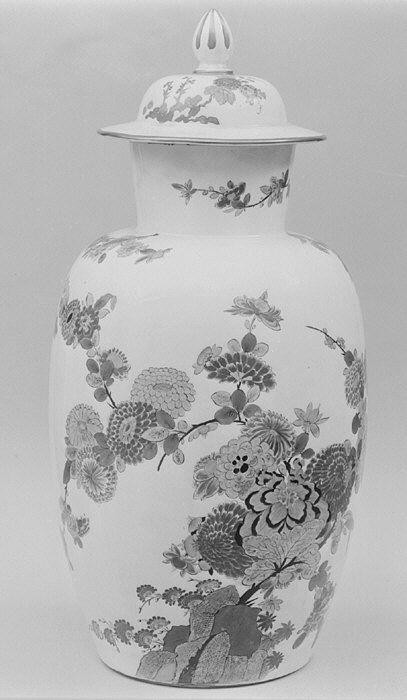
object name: vase with cover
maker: meissen manufactory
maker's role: manufactory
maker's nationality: german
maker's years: 1710-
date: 1725-1730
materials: hard paste porcelain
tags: flowers